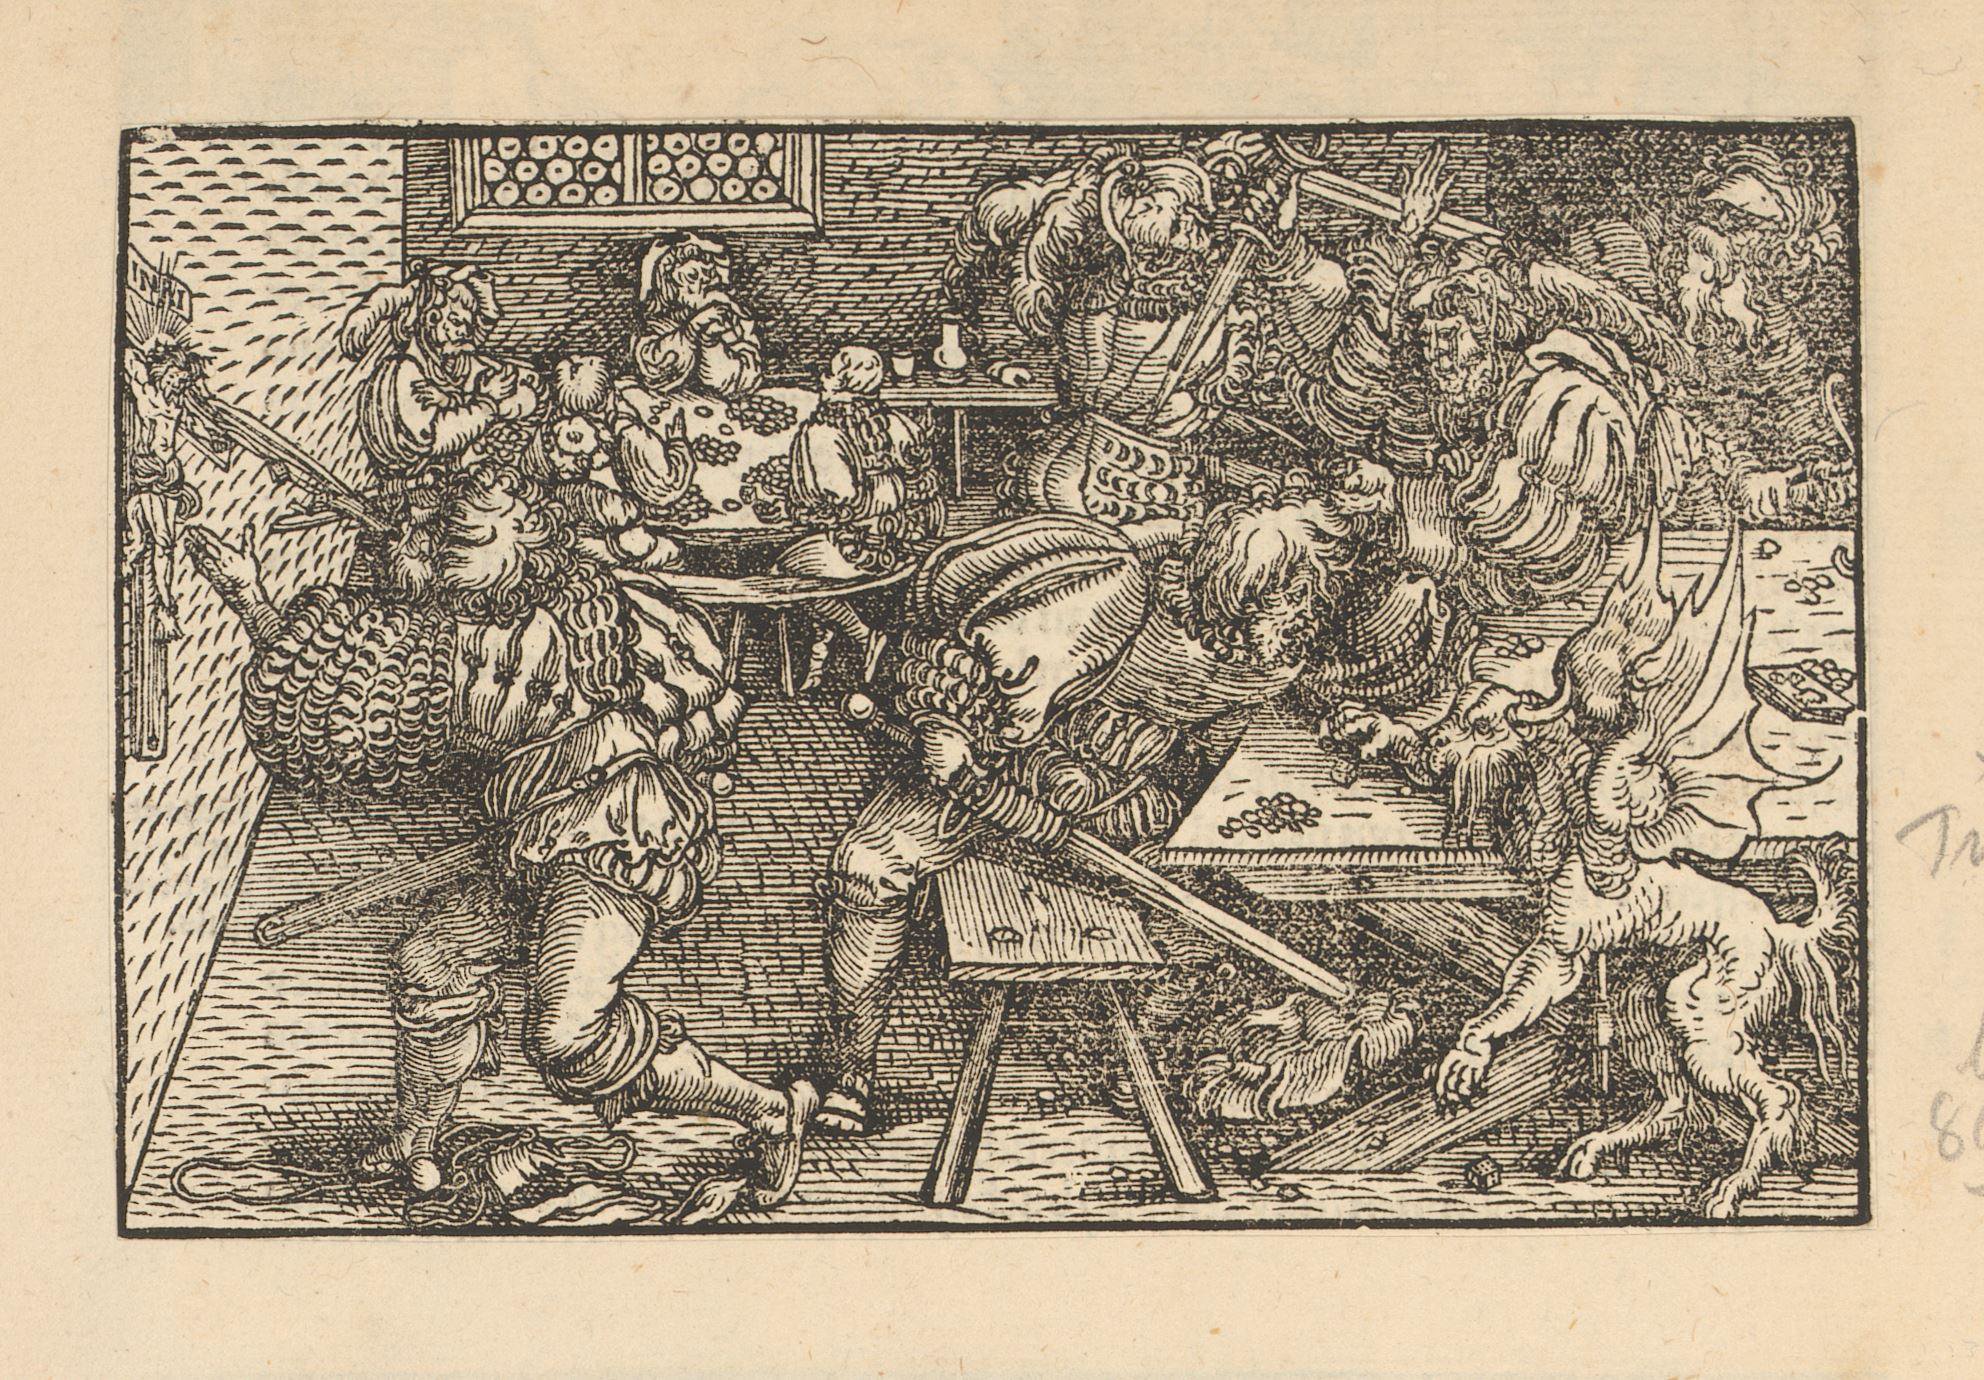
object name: book illustration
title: Gokkende en vechten mannen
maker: Anonymous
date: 1514-1532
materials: paper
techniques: letterpress printing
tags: gaming den, gambling den, drunken brawl (usually peasants fighting in an inn)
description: Deze prent is gebruikt in: Petrarca, Francesco. Von der Artzney bayder Glück, des guten und widerwertigen: unnd weß sich ain yeder inn Gelück und Unglück halten sol (...). Augsburg: Heinrich Steiner, 1532. Deze uitgave is ook bekend onder de titel 'Trostspiegel in Glück und Unglück'.